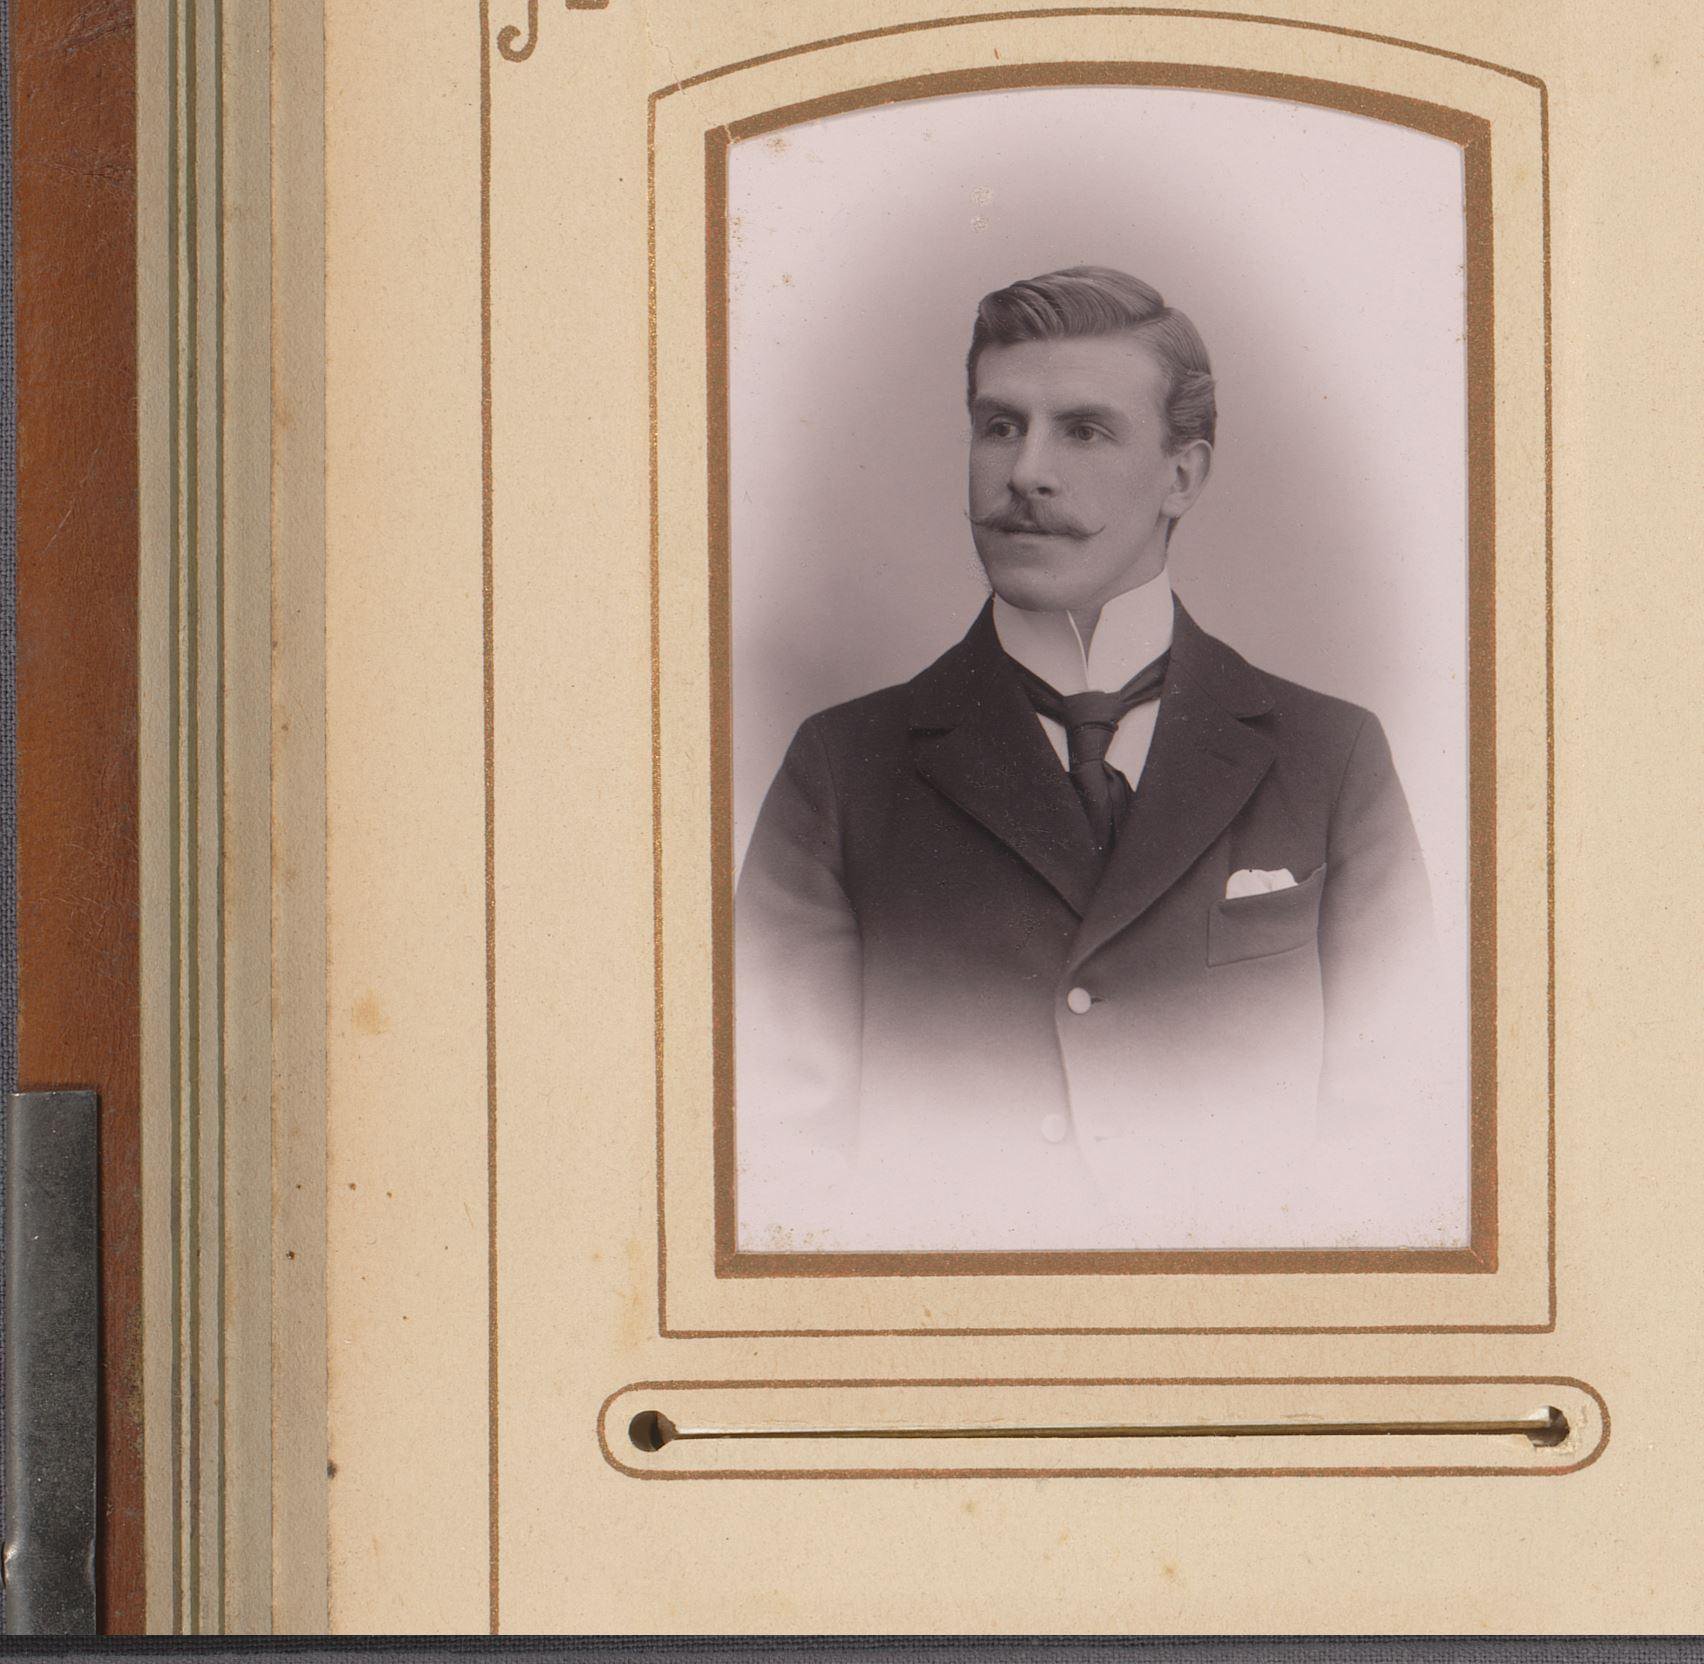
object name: album leaf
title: Portret van een man met snor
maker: willy schaarschmidt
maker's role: fotograaf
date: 1899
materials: cardboard, photographic support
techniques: collodion silver print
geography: leipzig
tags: moustache, historical persons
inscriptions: inscription: ‘Willy Schaarschmidt/ Photograph/ Leipzig/ Nürenbergerstr. 49’, annotation: ‘With kindest regards/ Robert [Philps]/ 1899’